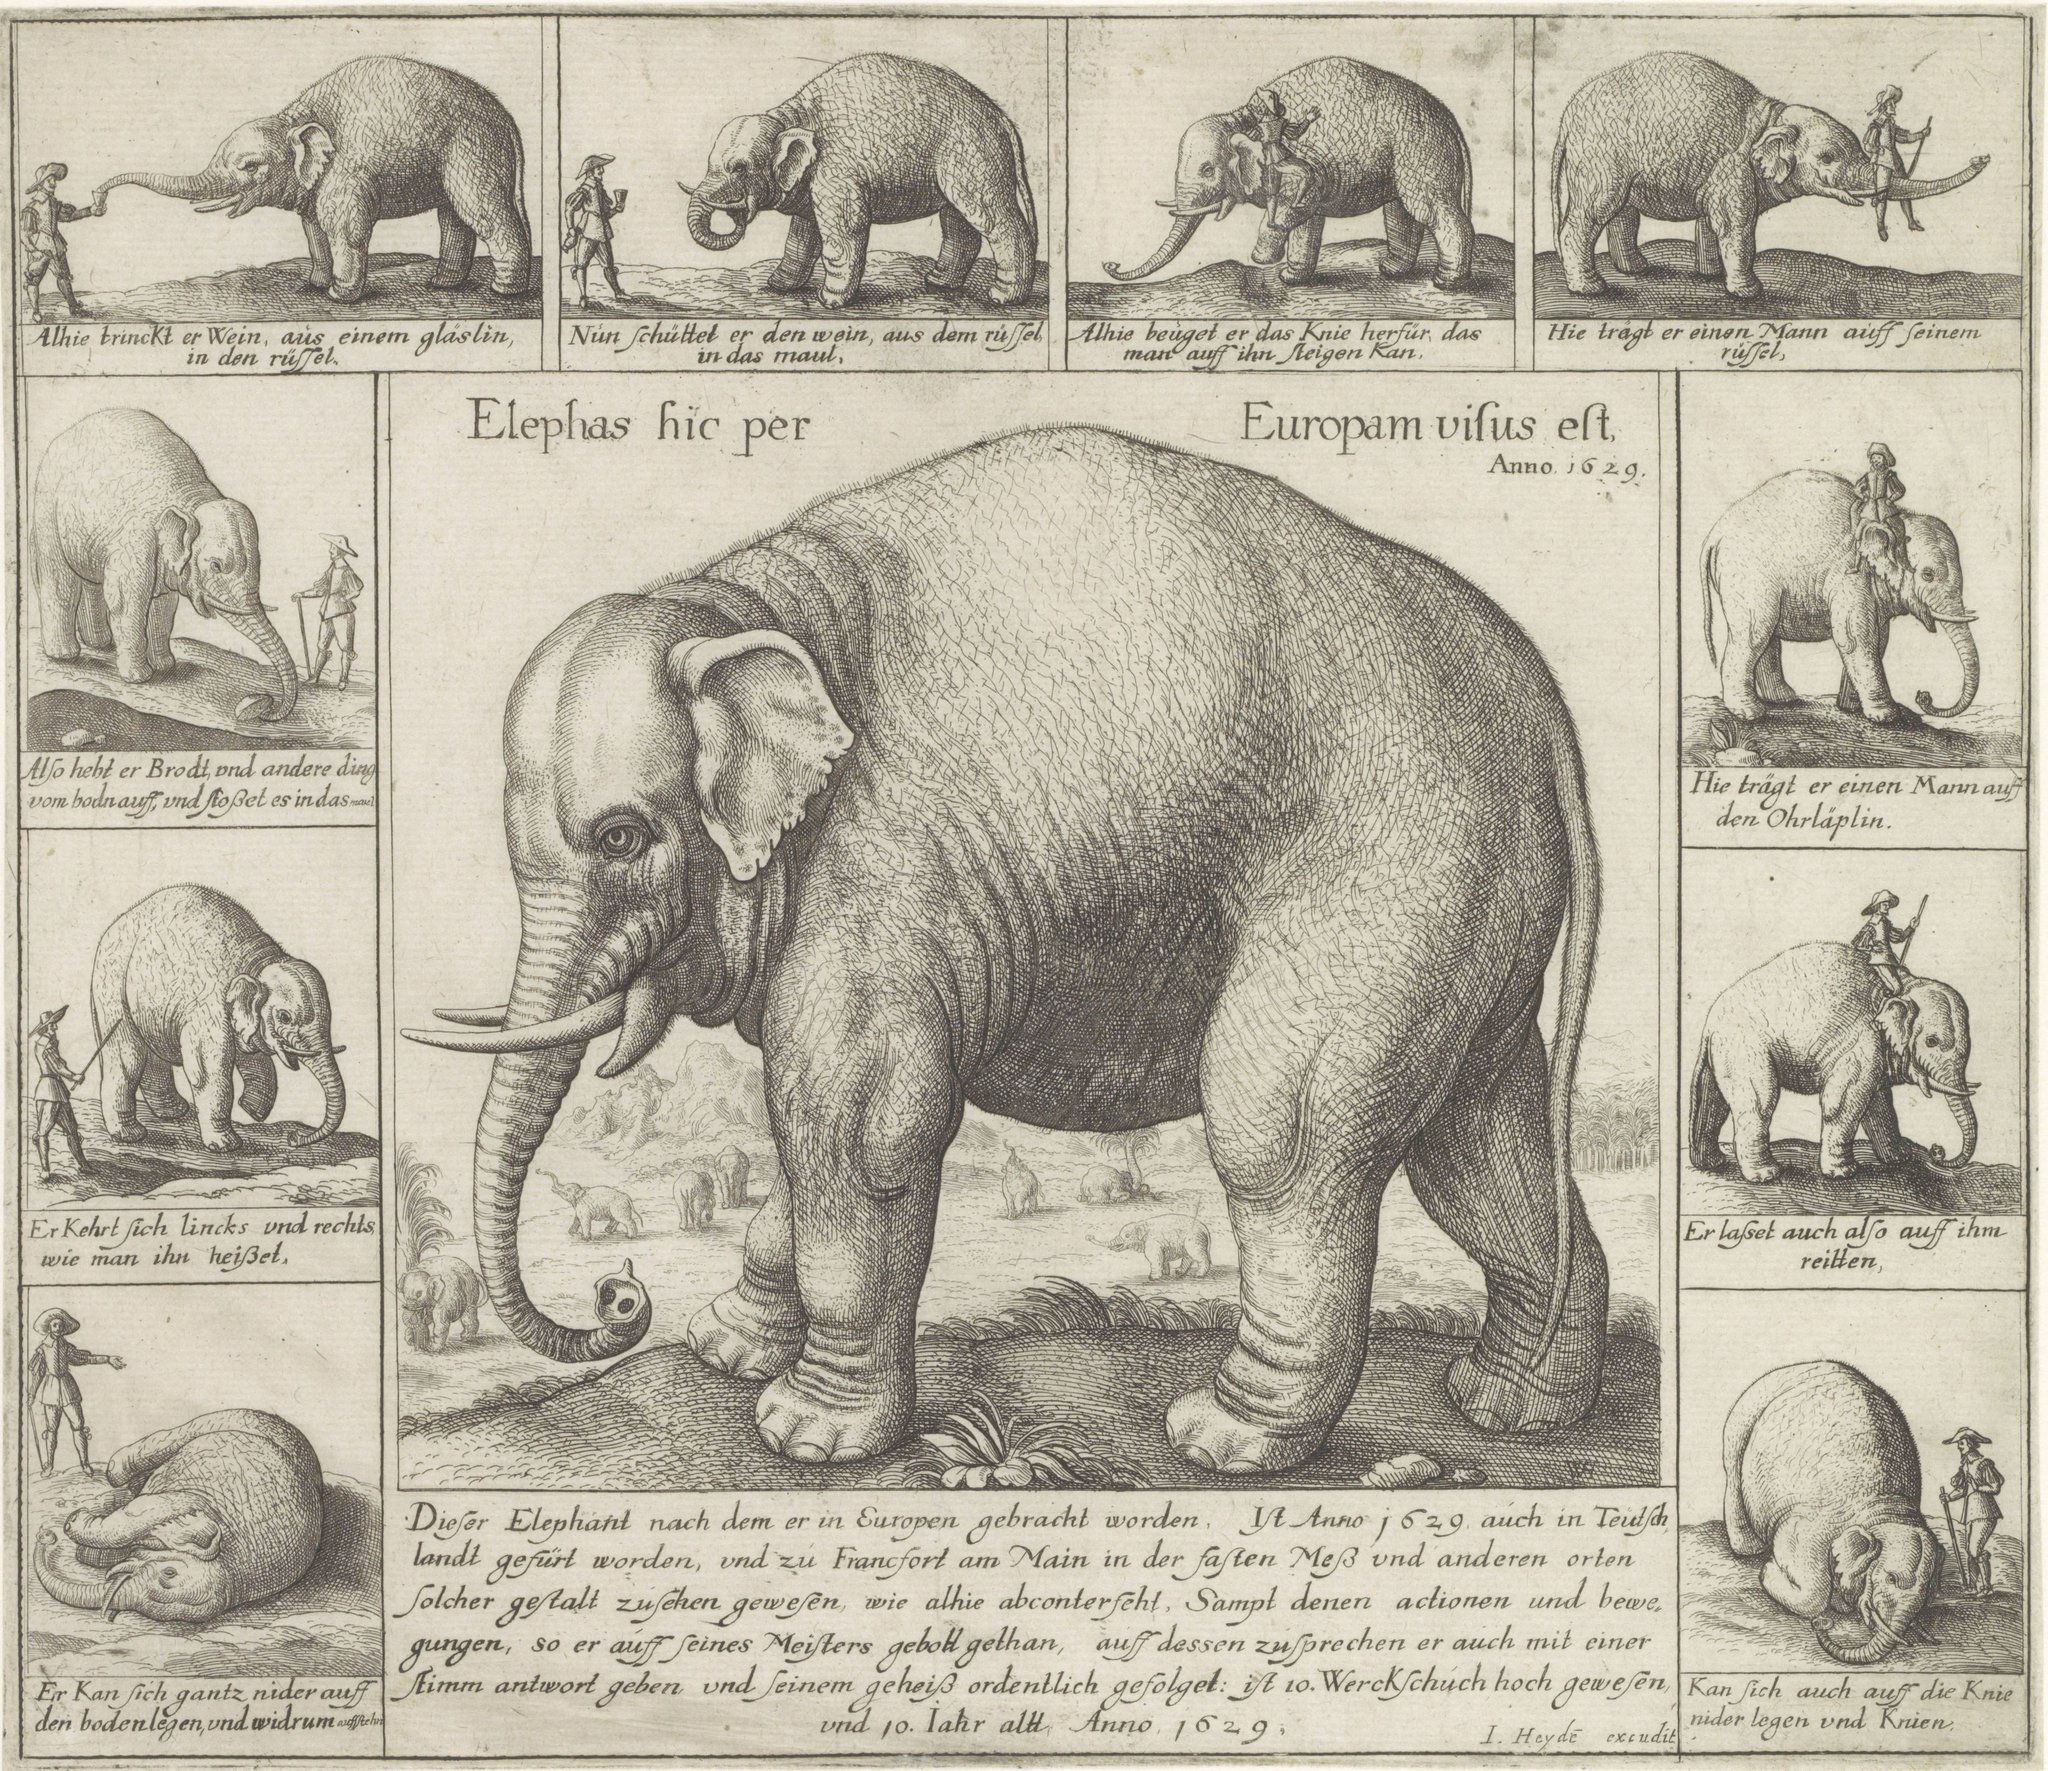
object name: print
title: Elephas hic per Europam visus est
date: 1629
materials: paper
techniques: etching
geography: germany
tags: taming and training of animals, trunked animals: elephant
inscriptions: collector's mark: Lugt 2760, collector's mark: Lugt 2228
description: Centraal de weergave van een tamme olifant. Hieromheen tien kleinere illustraties met de weergave van verschillende kunstjes die de olifant op aanwijzingen van een dresseur uitvoert.